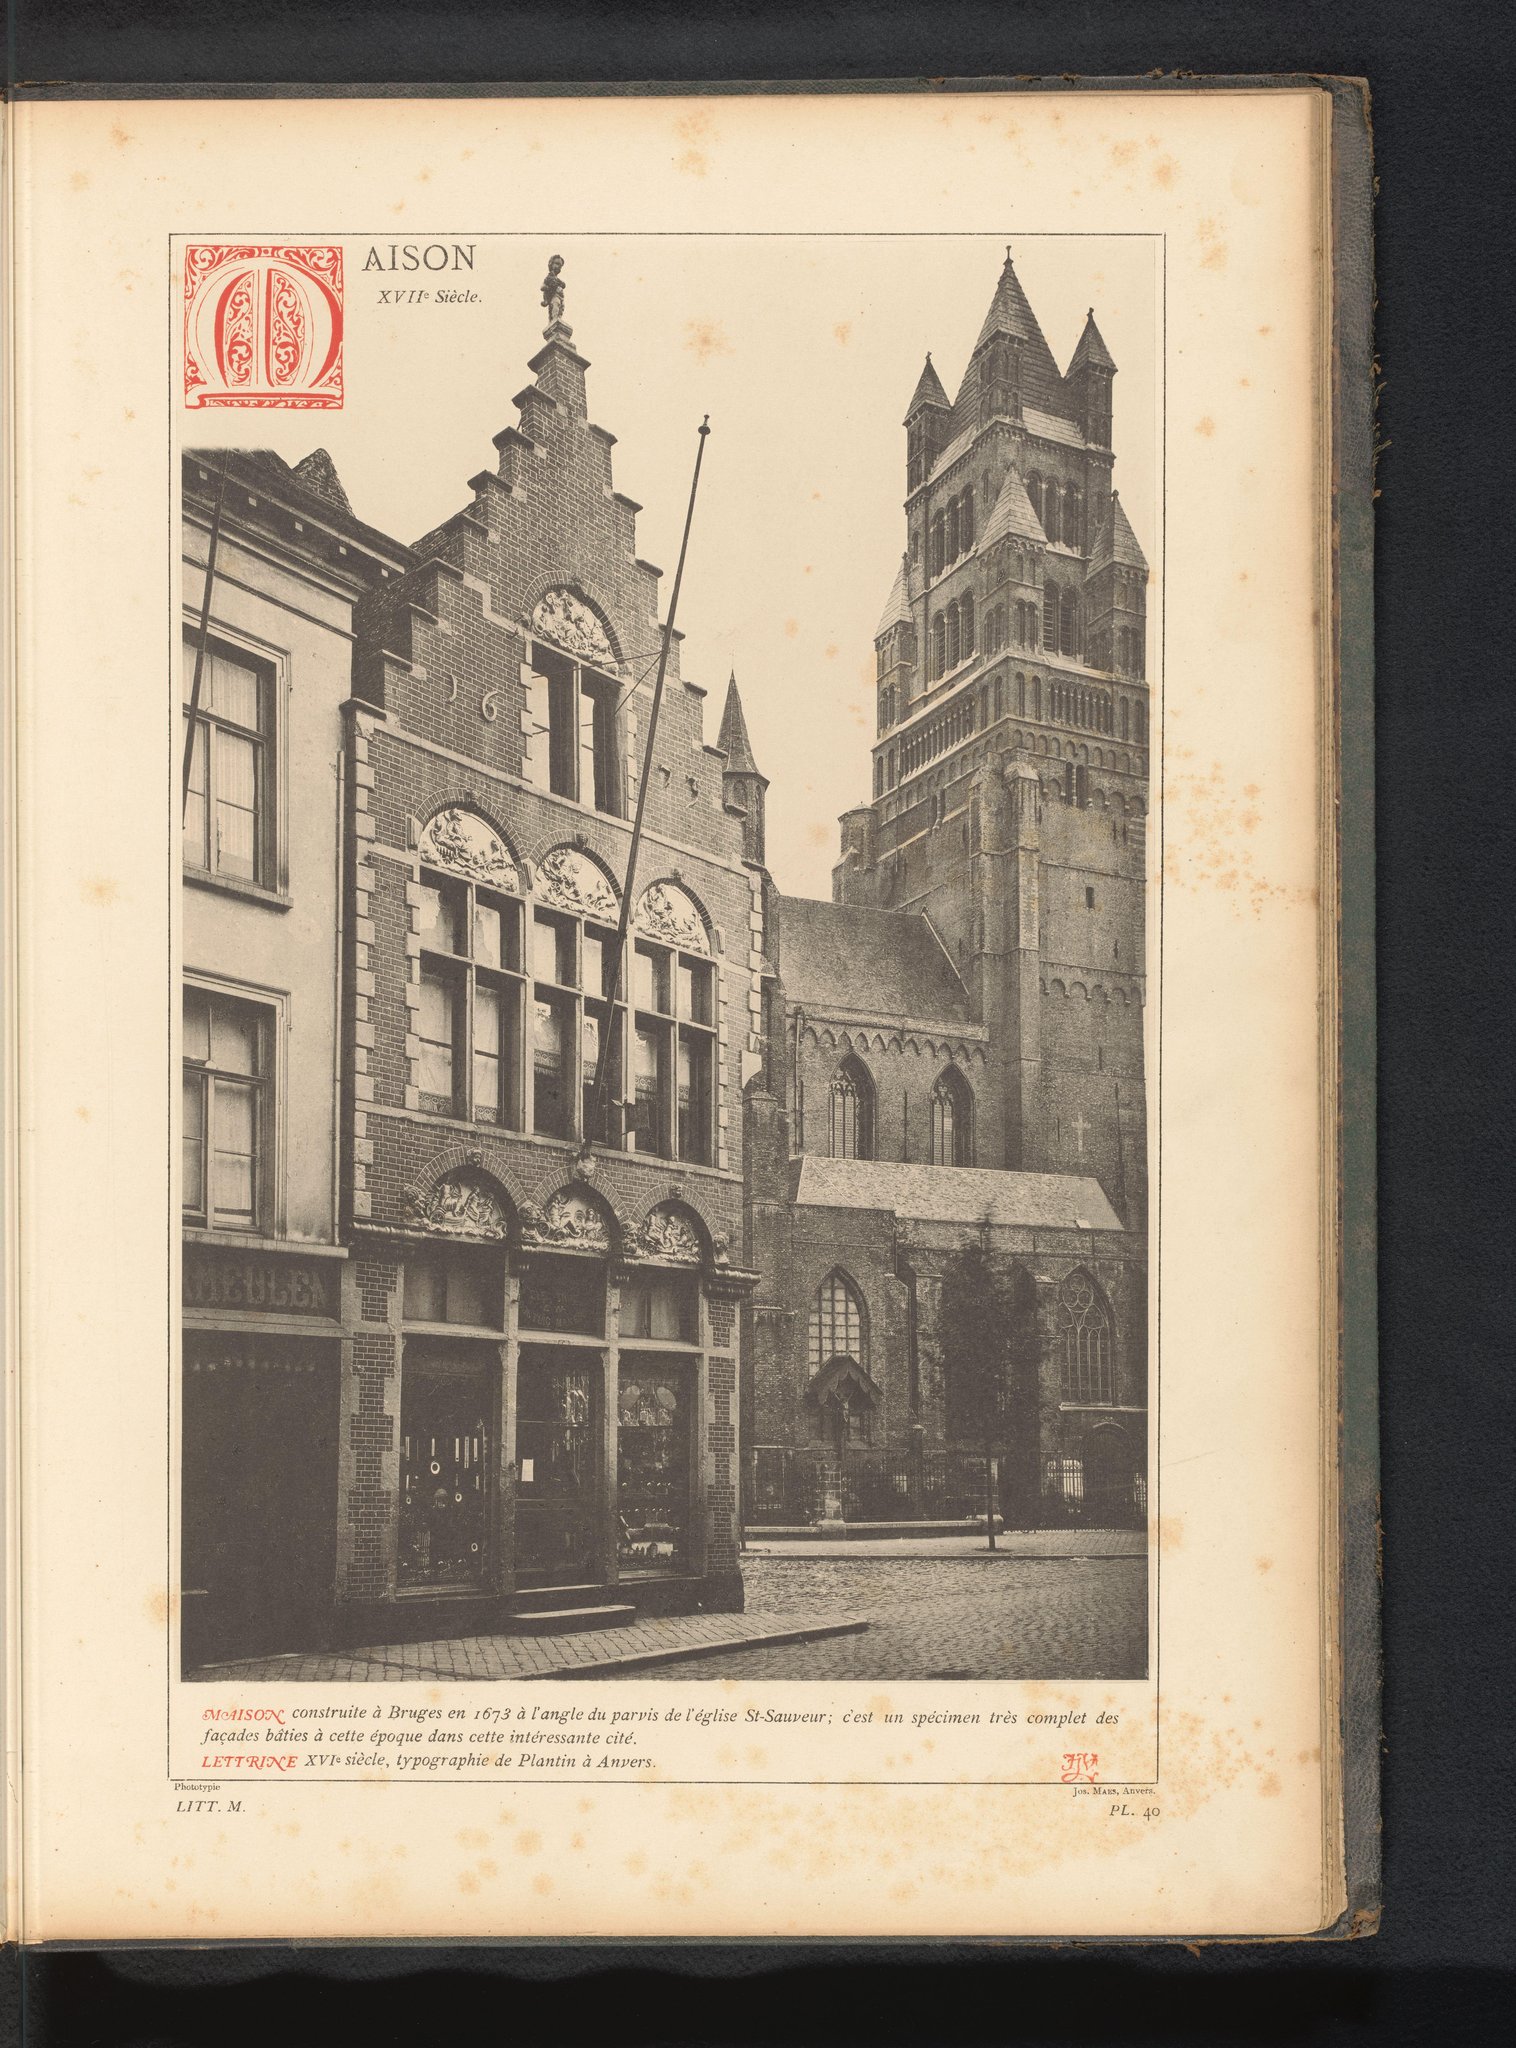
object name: page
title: Maisons, XVIIe Siècle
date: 1875-1880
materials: paper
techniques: photograph, photolithography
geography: bruges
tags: civic architecture; edifices; dwellings, bruges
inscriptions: inscription: ‘MAISON construite à (...)’, monogram: ‘JJvY’, inscription: ‘LITT. M. - PL. 40’